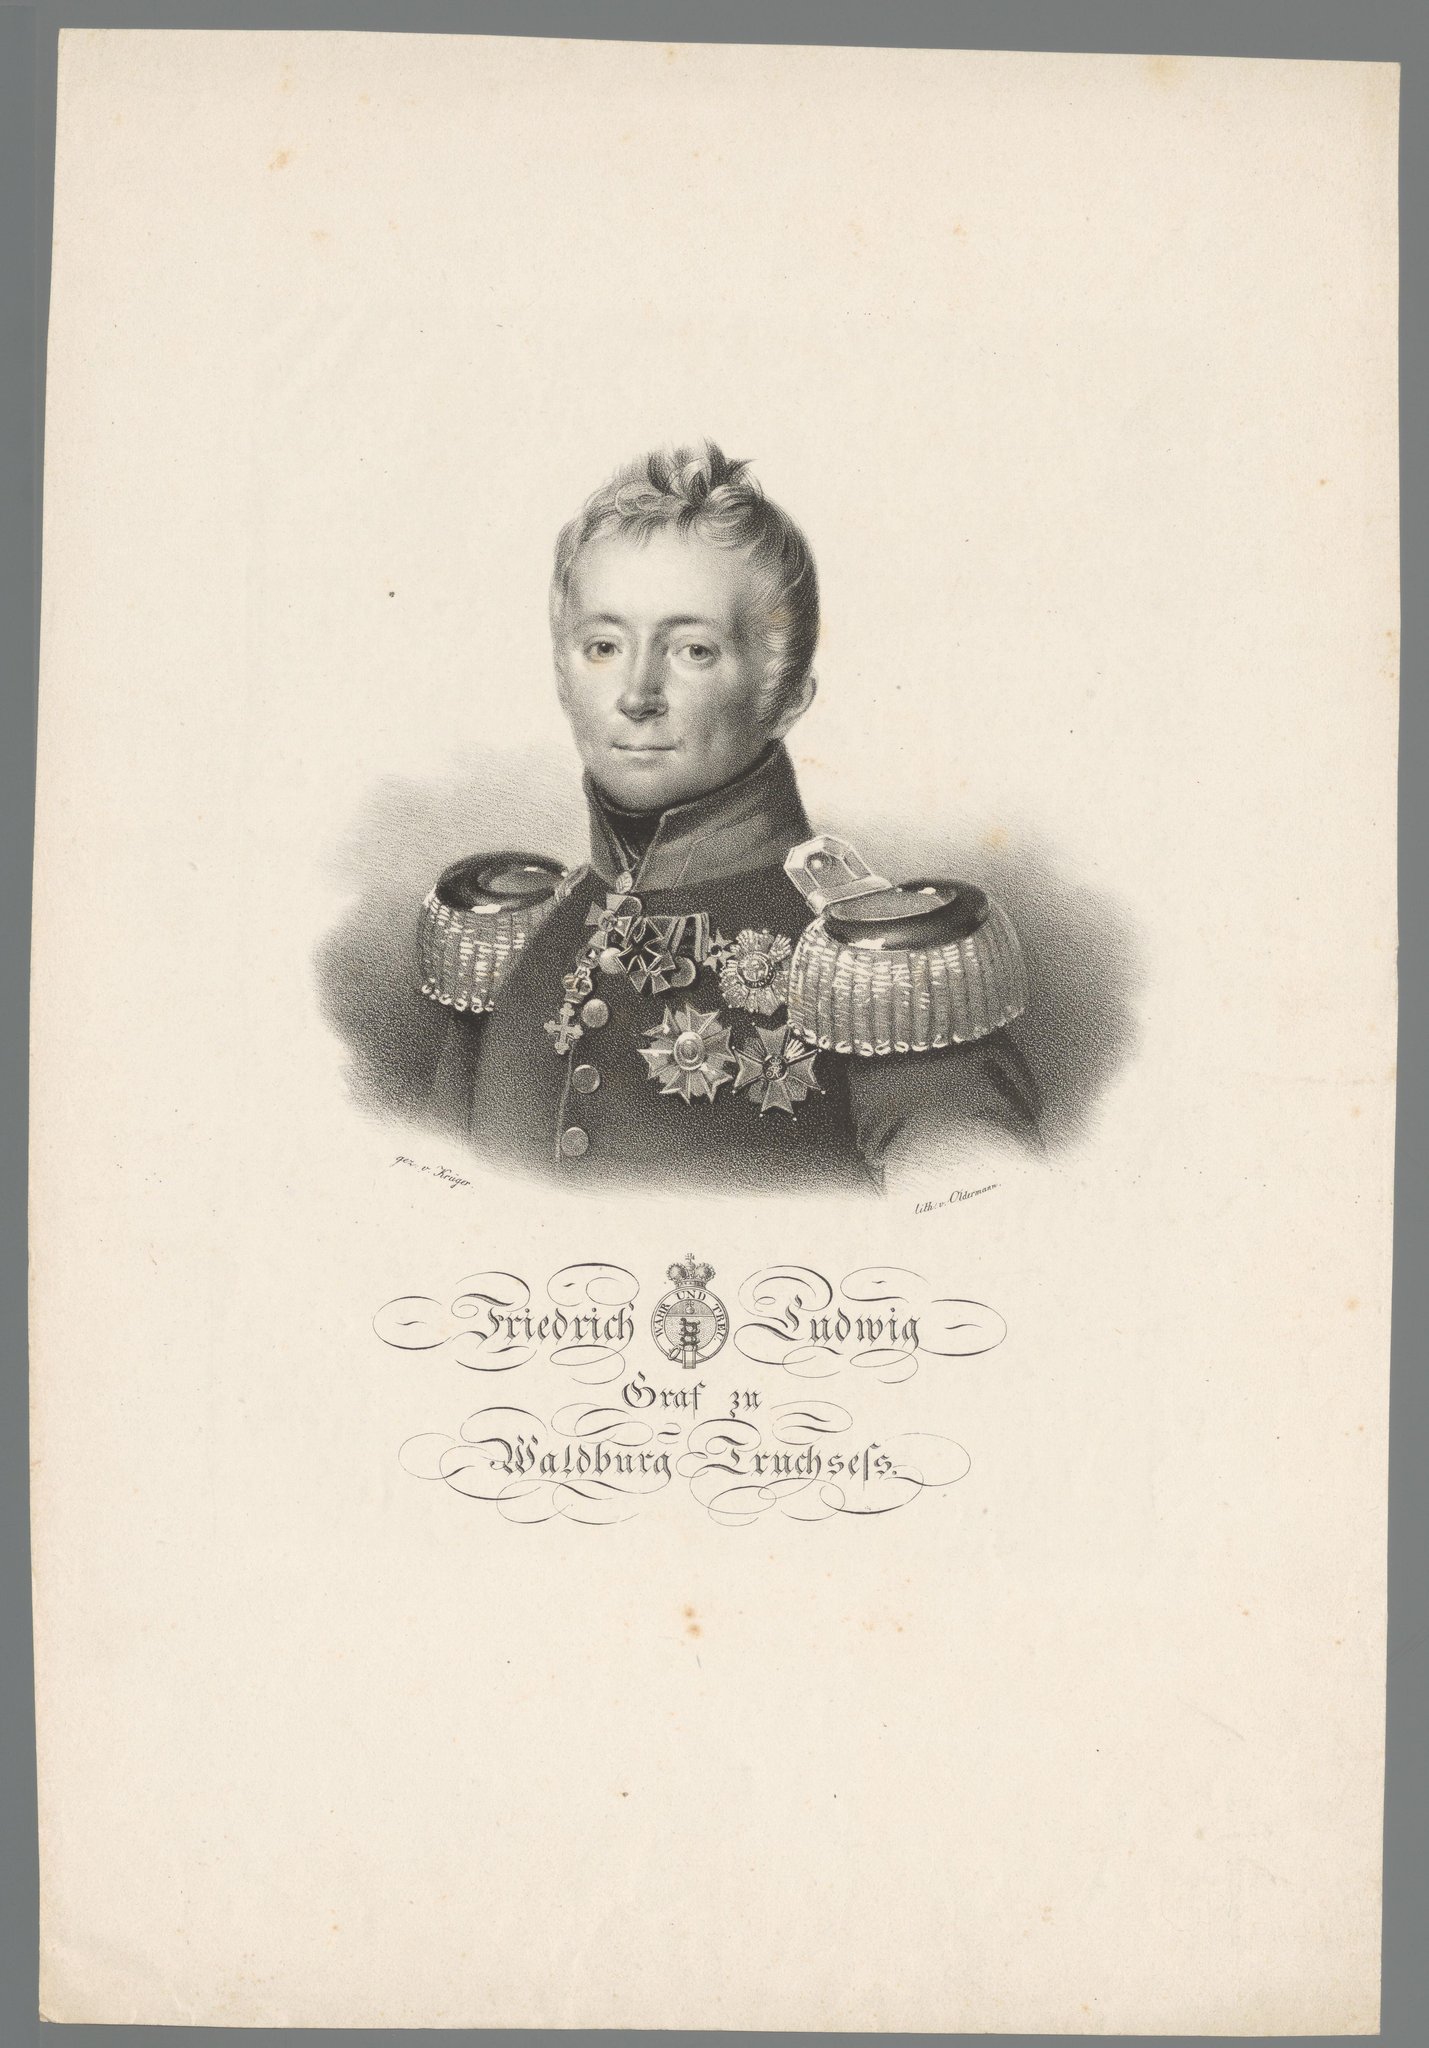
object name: print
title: Friedrich Ludwig Waldburg Truchsess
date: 1812-1874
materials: paper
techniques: lithograph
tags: politician, commander-in-chief, general, marshal, historical persons, politician, e.g. party leader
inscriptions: collector's mark: Lugt 2228